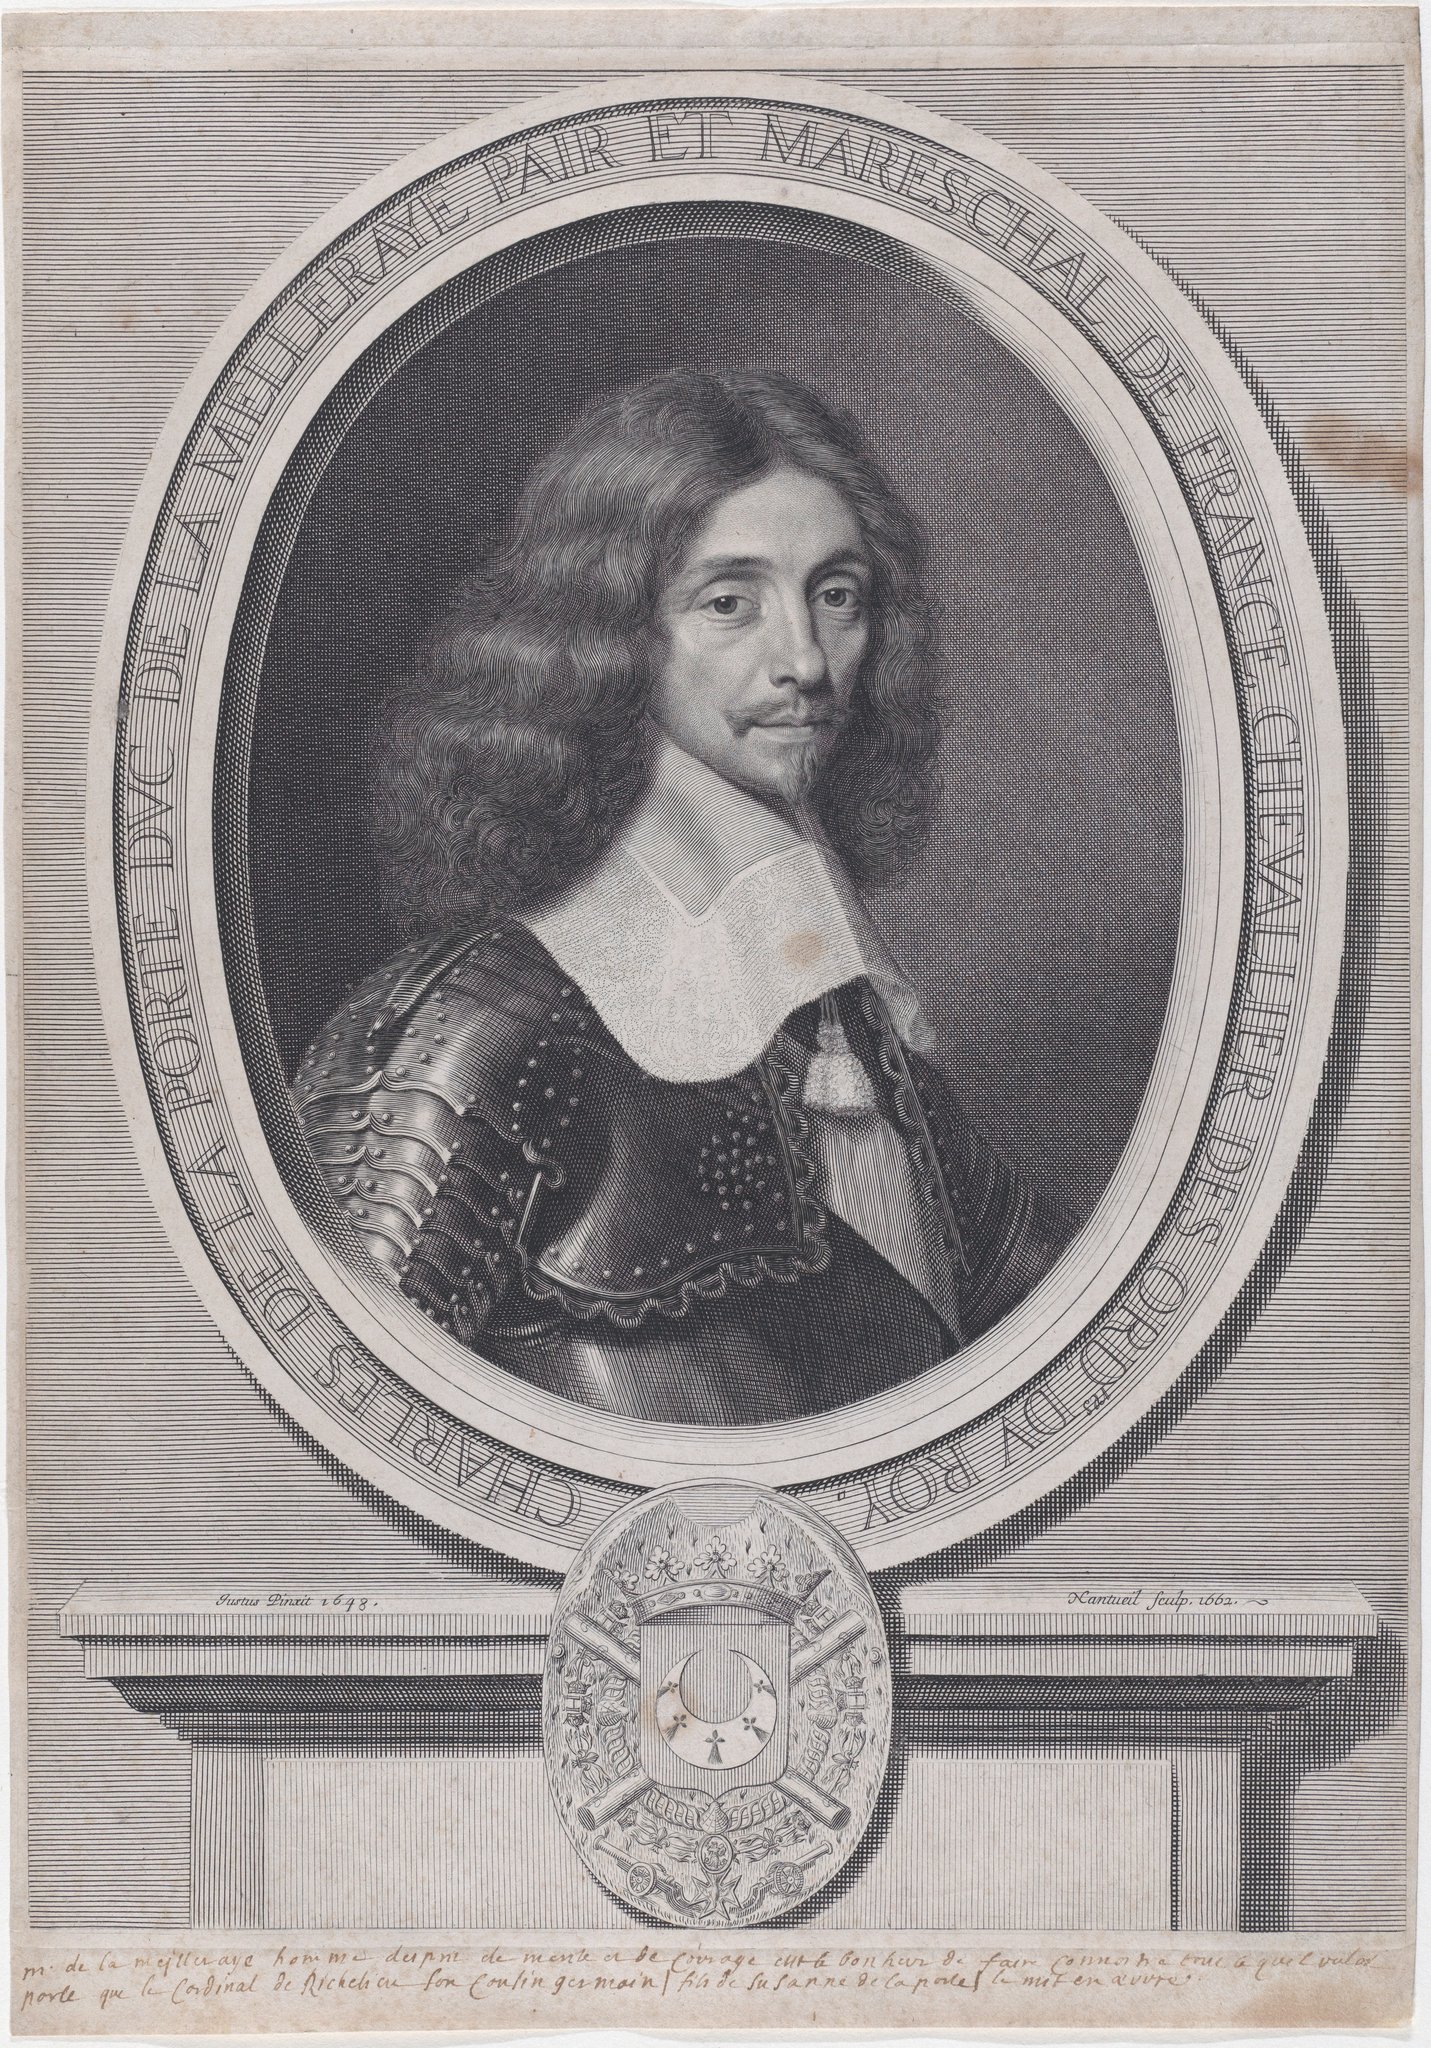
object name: print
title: Portrait of Charles de la Porte Duc de la Melleraye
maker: robert nanteuil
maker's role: artist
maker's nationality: french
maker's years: 1623-1678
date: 1662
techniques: engraving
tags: men,portraits